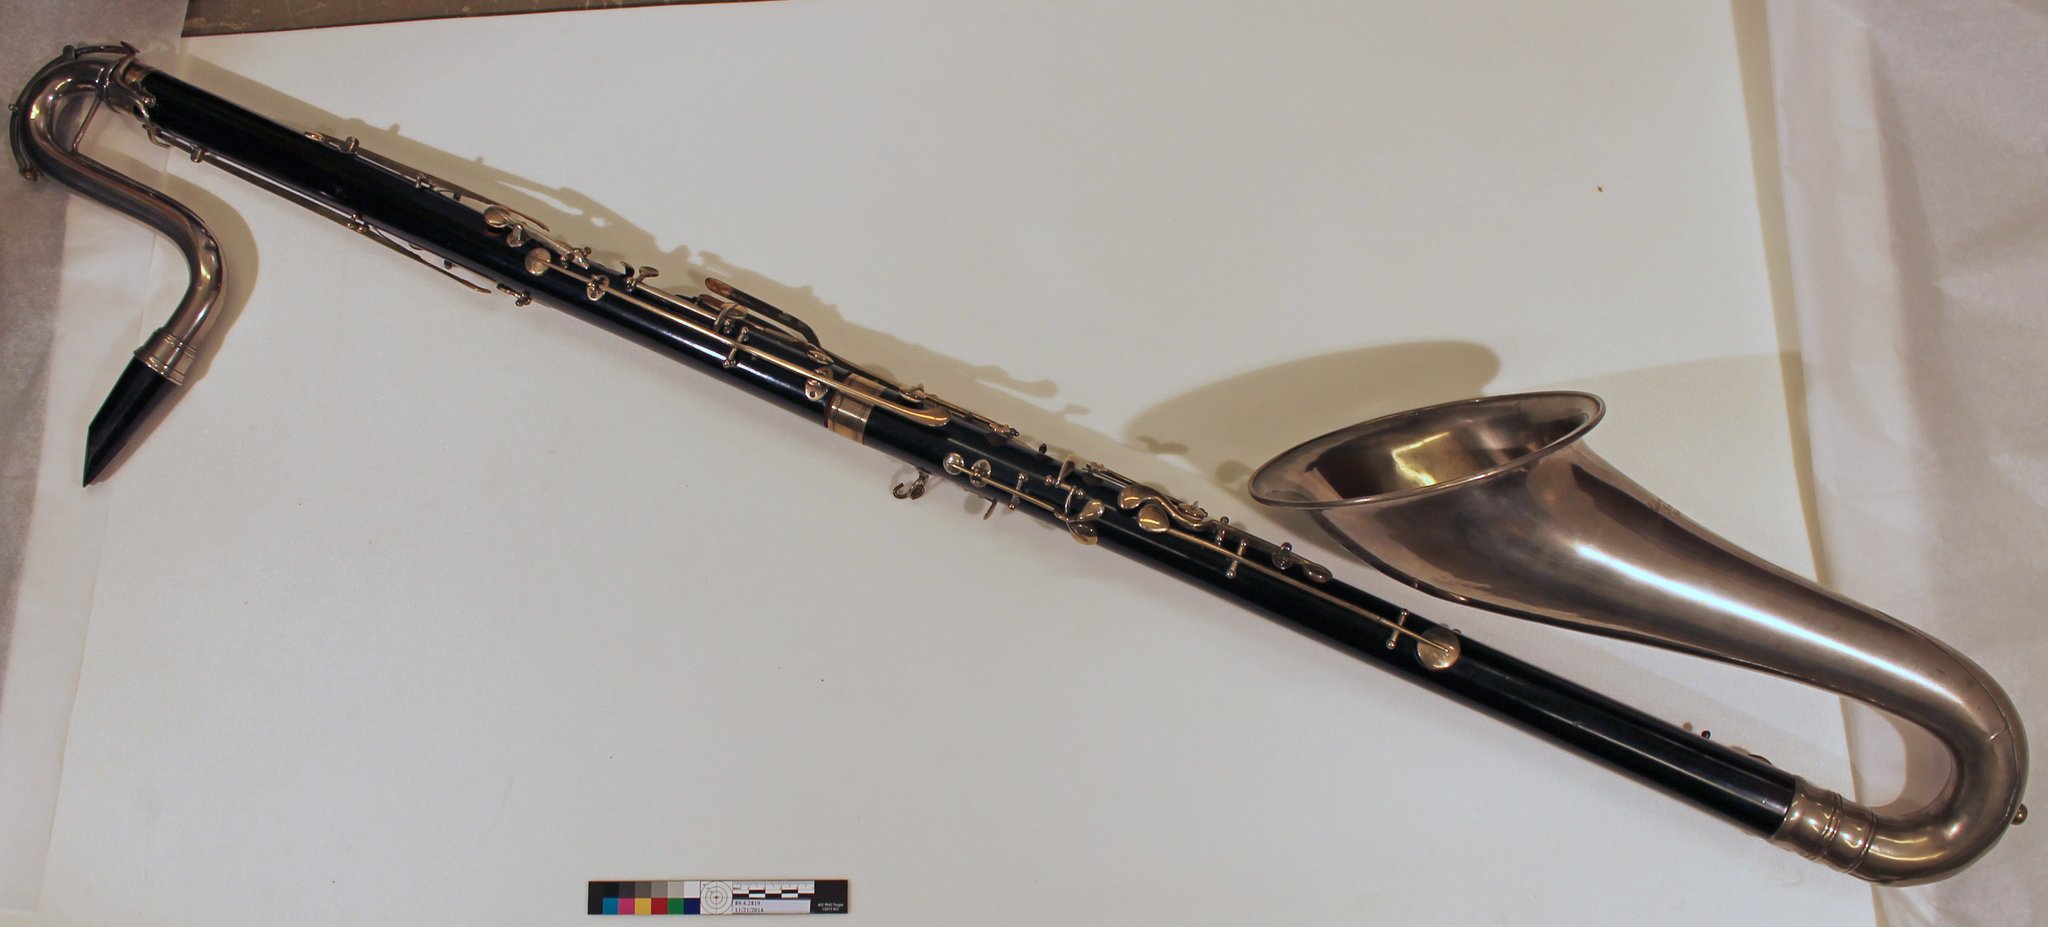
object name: contra alto clarinet in e flat clarone grande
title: Contrat Alto Clarinet in E-flat (Clarone grande)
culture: italian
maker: alessandro maldura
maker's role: maker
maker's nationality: italian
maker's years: 1850-1914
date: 1881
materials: nickel, silver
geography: italy